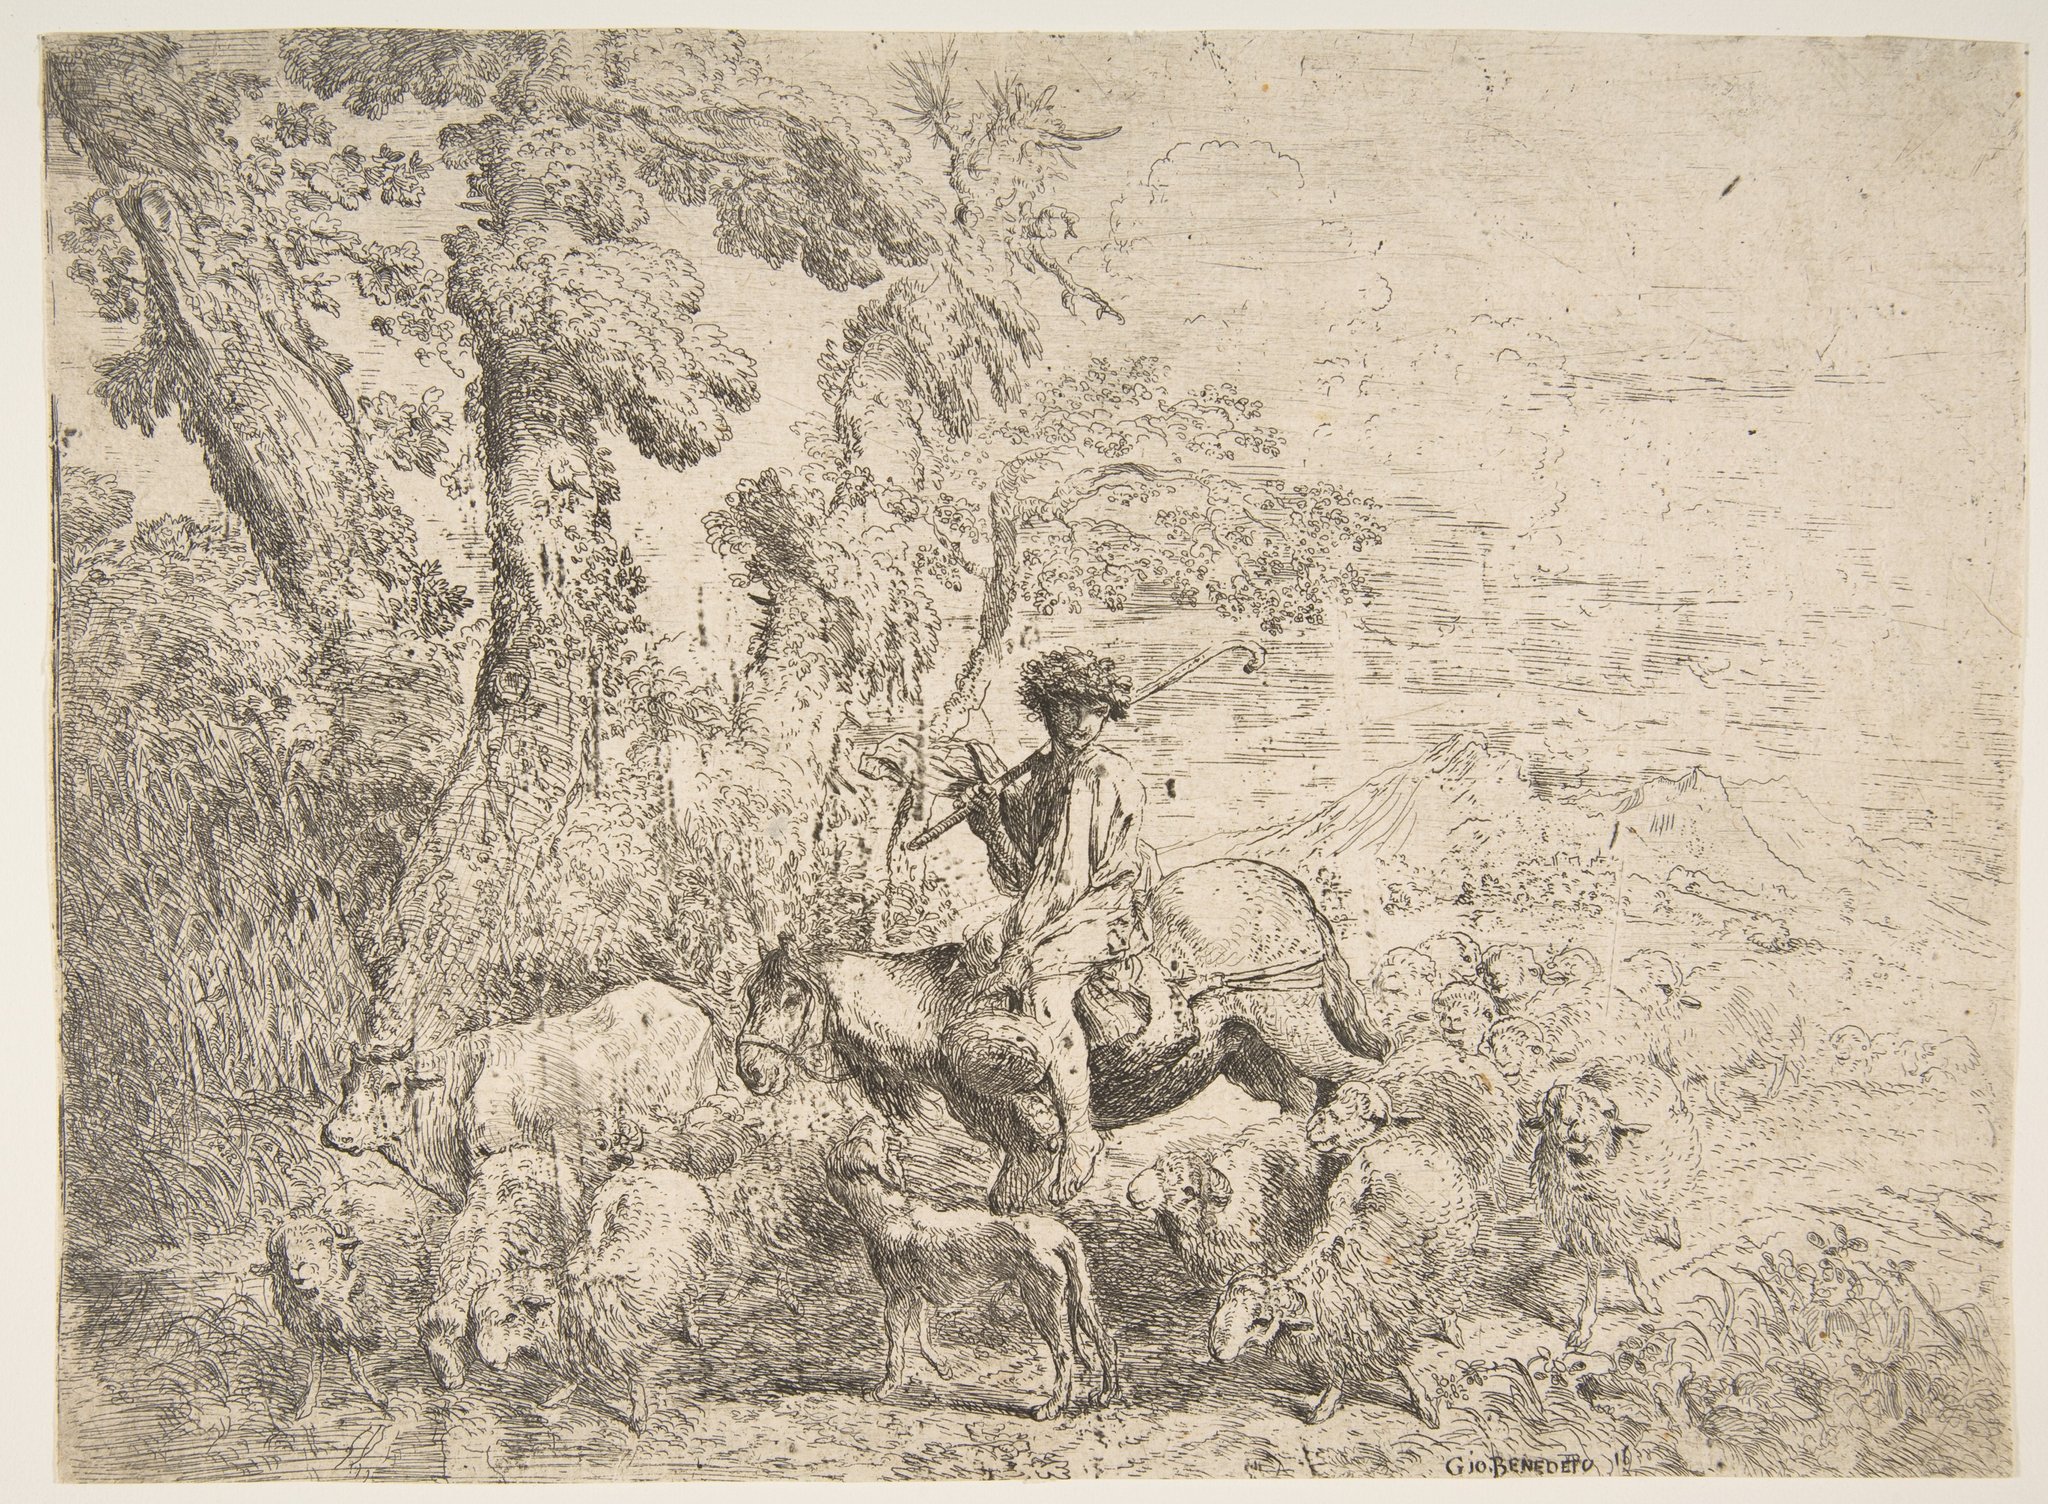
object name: print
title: Young herdsman on horseback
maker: giovanni benedetto castiglione (il grechetto)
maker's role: artist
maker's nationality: italian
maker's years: 1609-1664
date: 1638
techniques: etching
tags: animals,men,horses